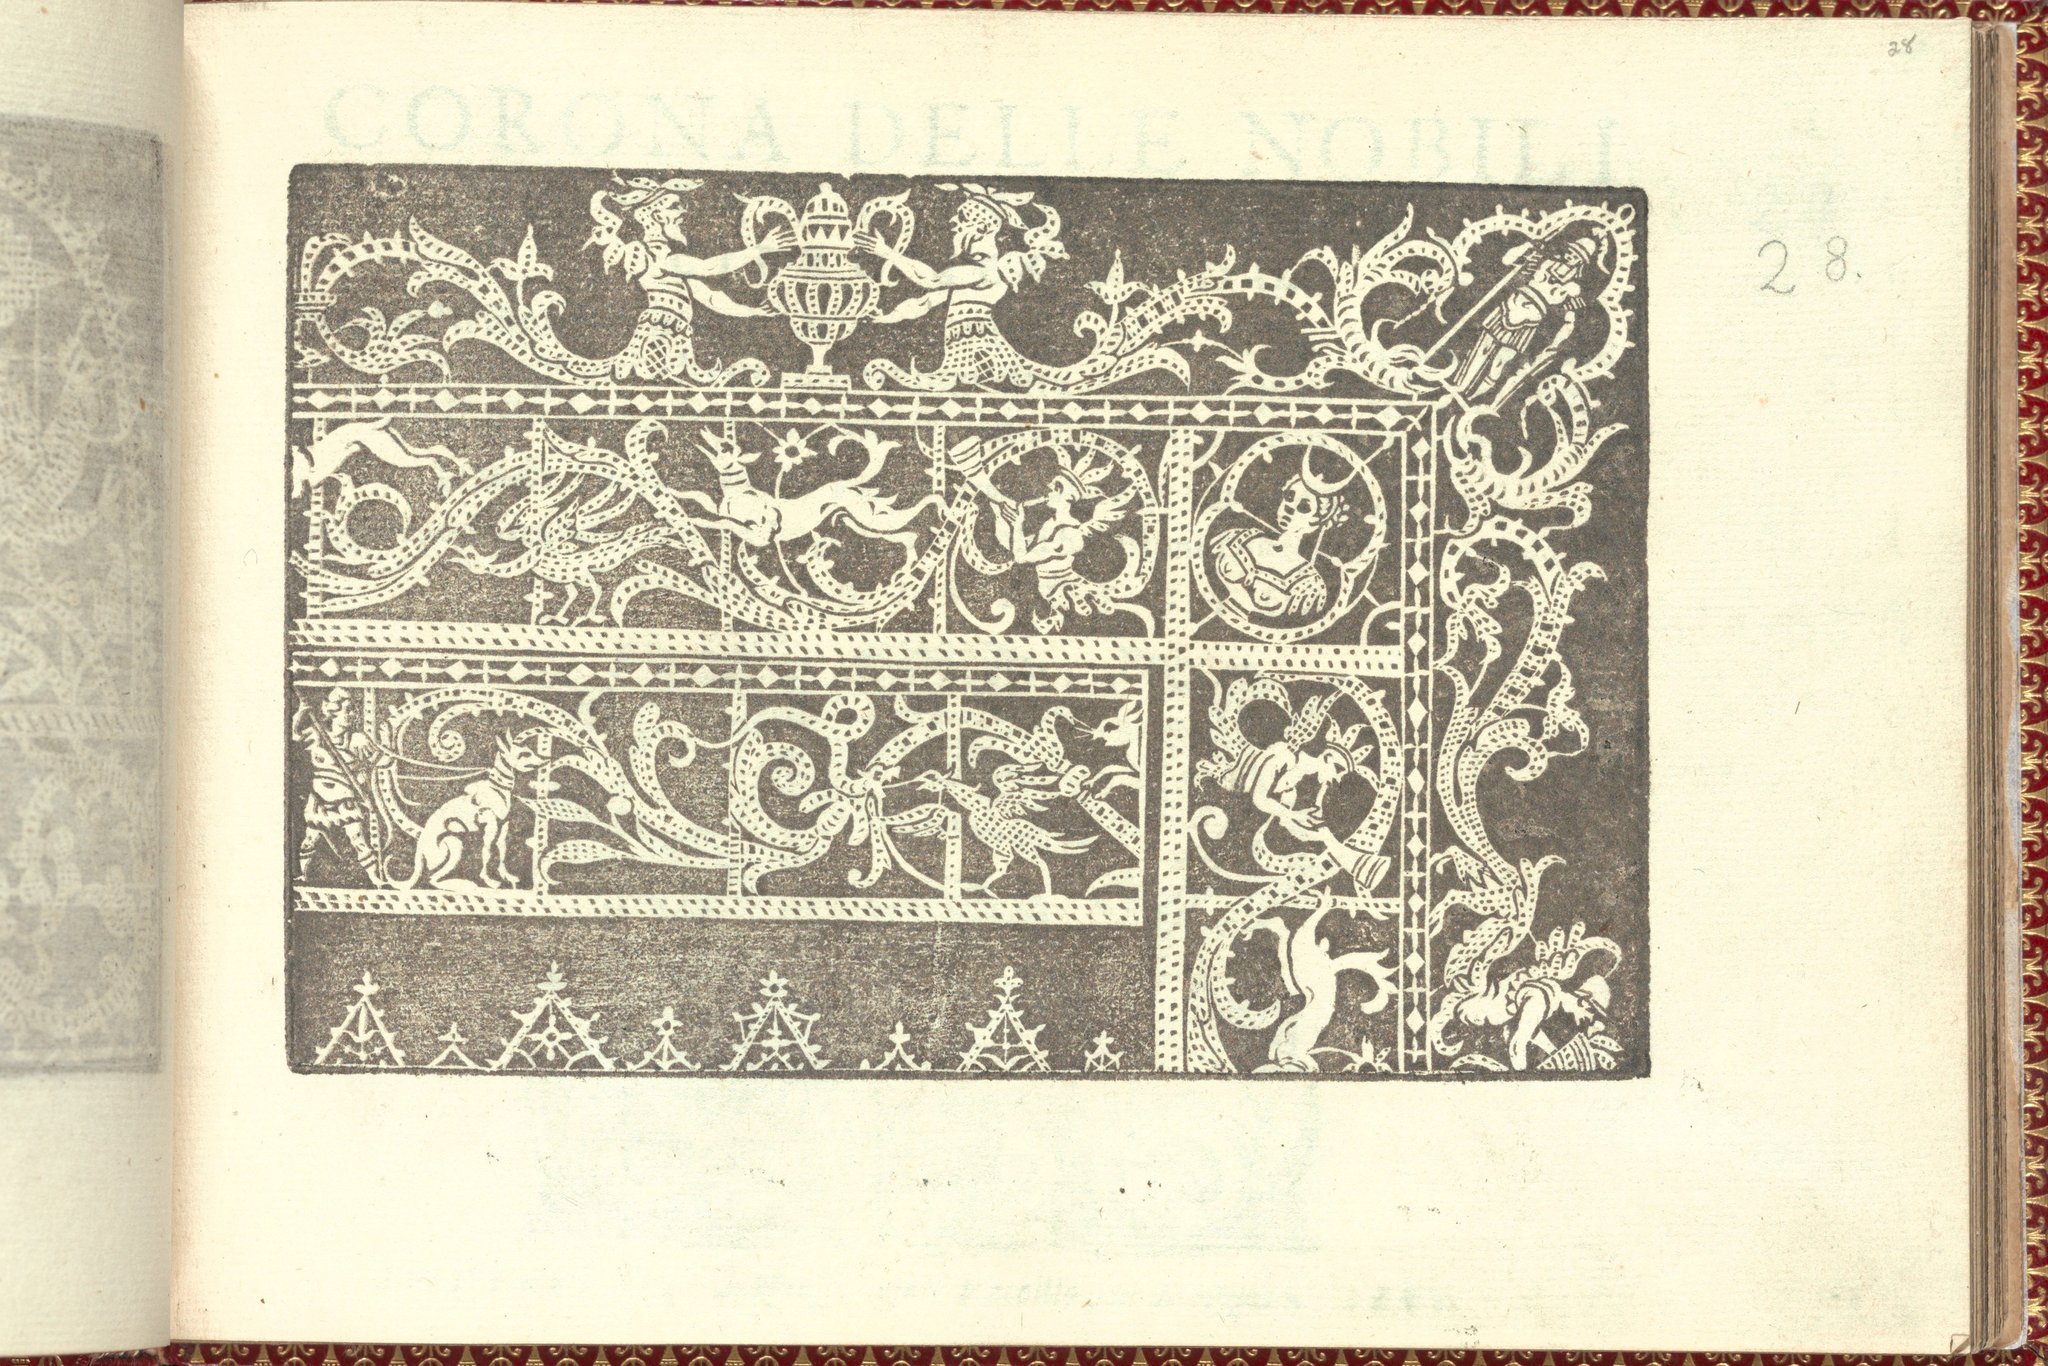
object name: book print ornament architecture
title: Corona delle Nobili et Virtuose Donne: Libro I-IV, page 28 (recto)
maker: cesare vecellio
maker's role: publisher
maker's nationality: italian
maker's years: 1521-1601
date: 1601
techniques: woodcut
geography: italy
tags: ornament,dogs